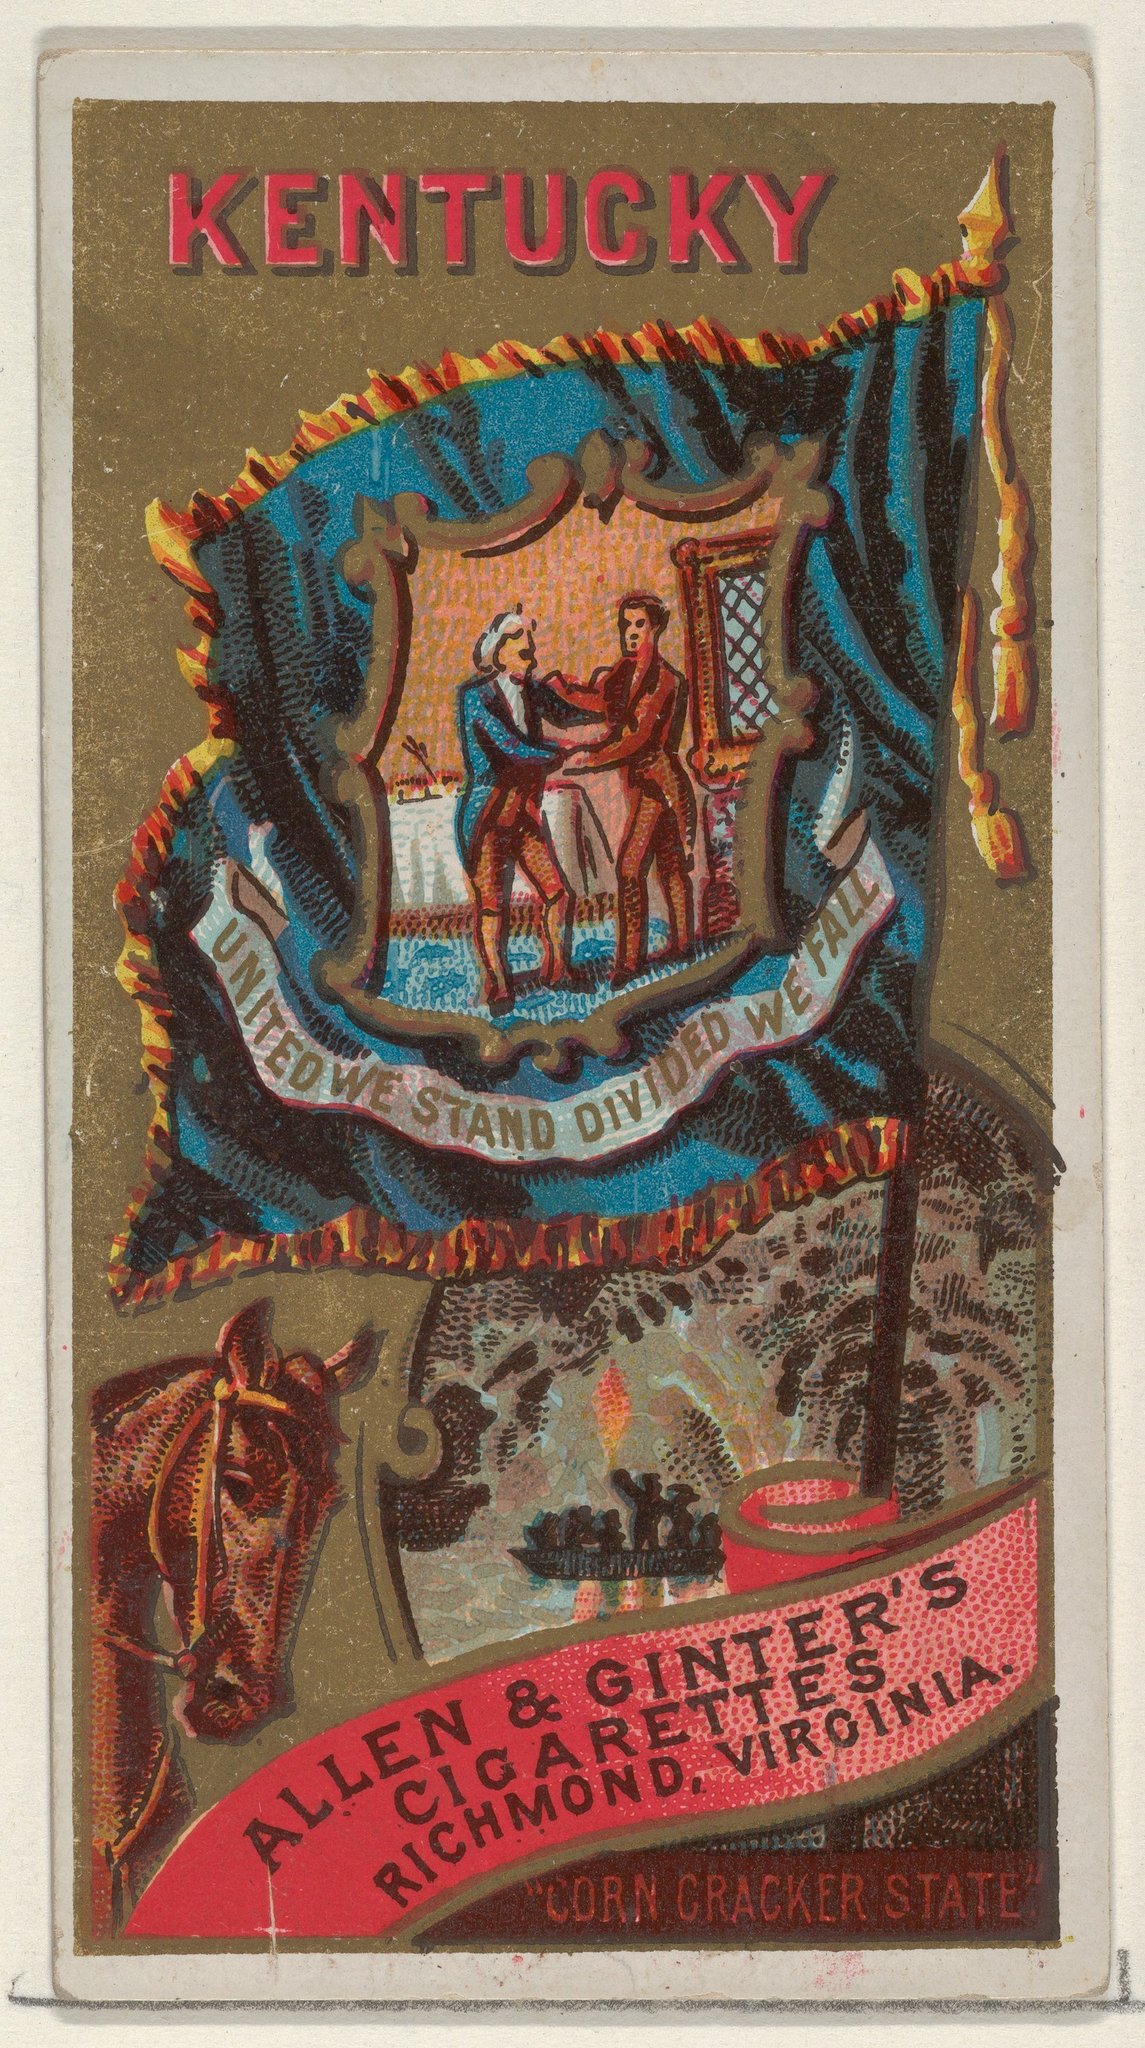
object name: print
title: Kentucky, from Flags of the States and Territories (N11) for Allen & Ginter Cigarettes Brands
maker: allen & ginter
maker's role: publisher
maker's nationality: american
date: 1888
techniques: color lithograph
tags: flags